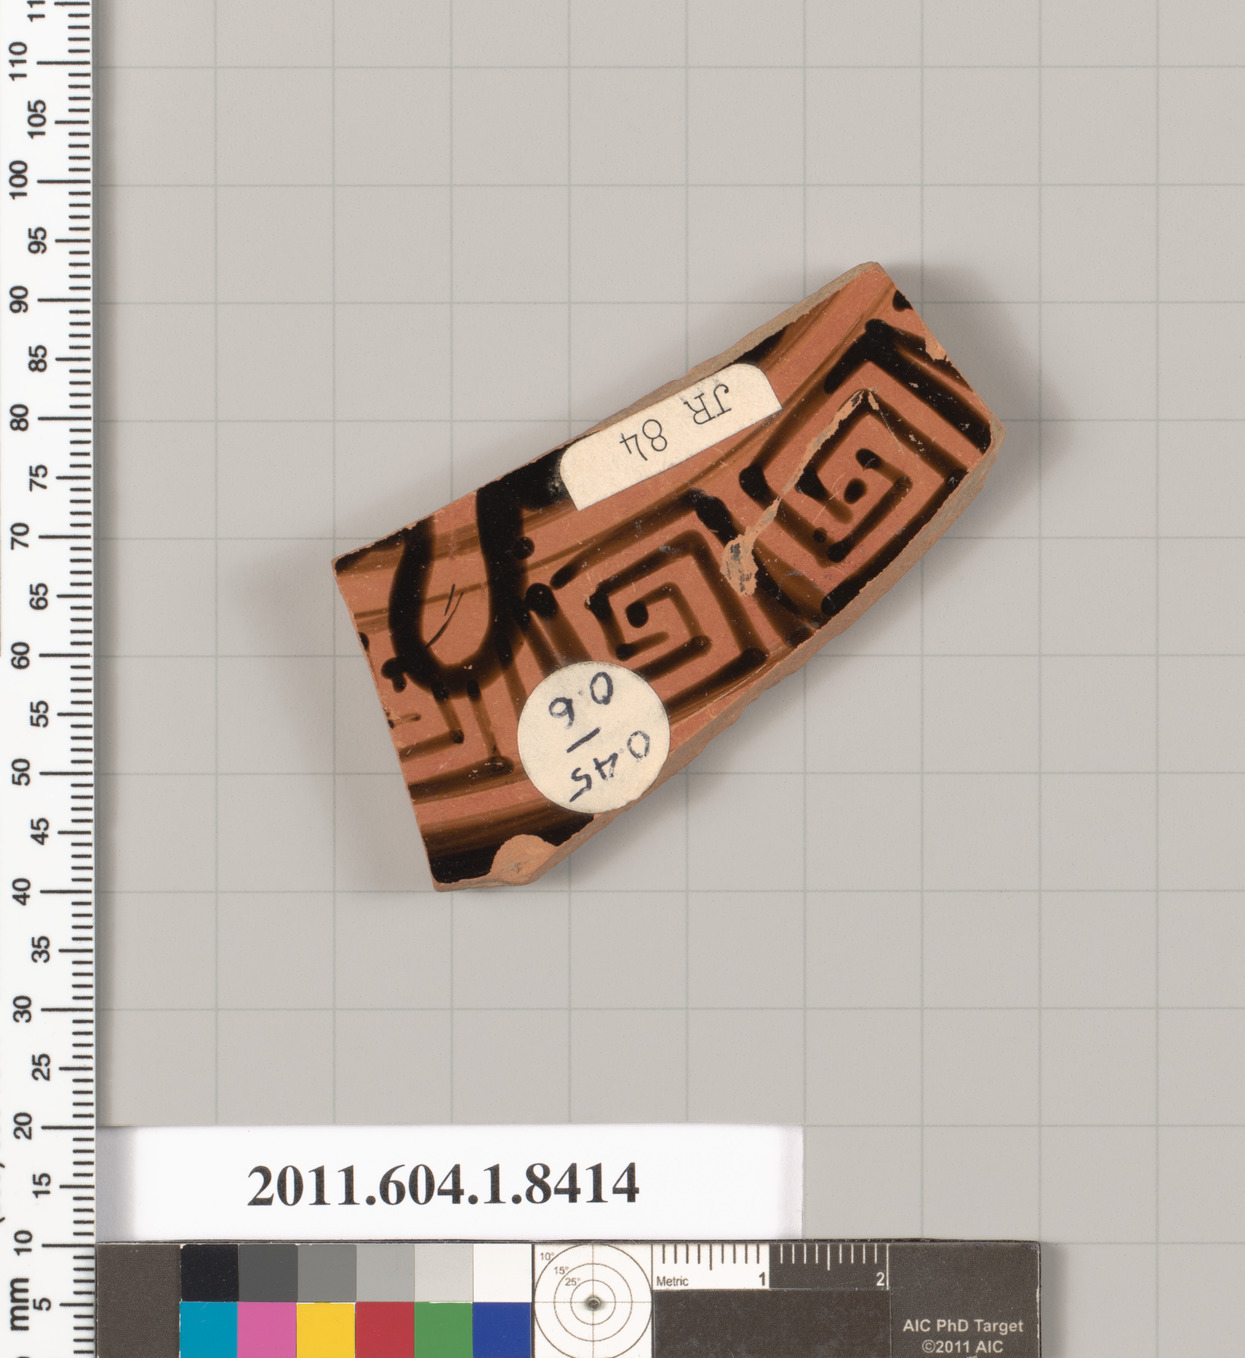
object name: kylix fragment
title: Terracotta fragment of a kylix (drinking cup)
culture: greek, attic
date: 351-375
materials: terracotta